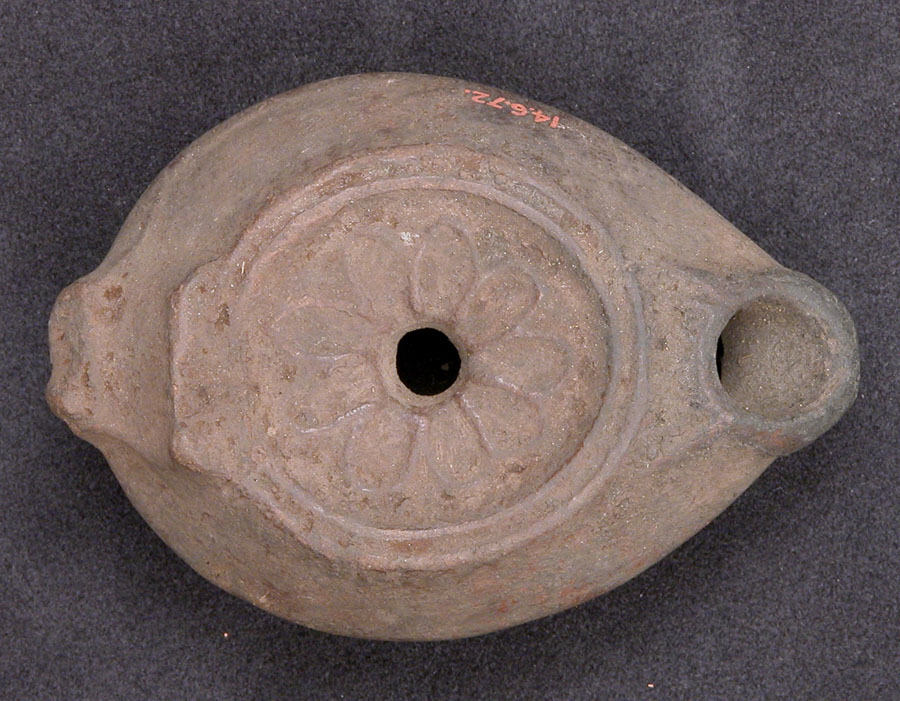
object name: lamp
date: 201-800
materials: earthenware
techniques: molding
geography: egypt